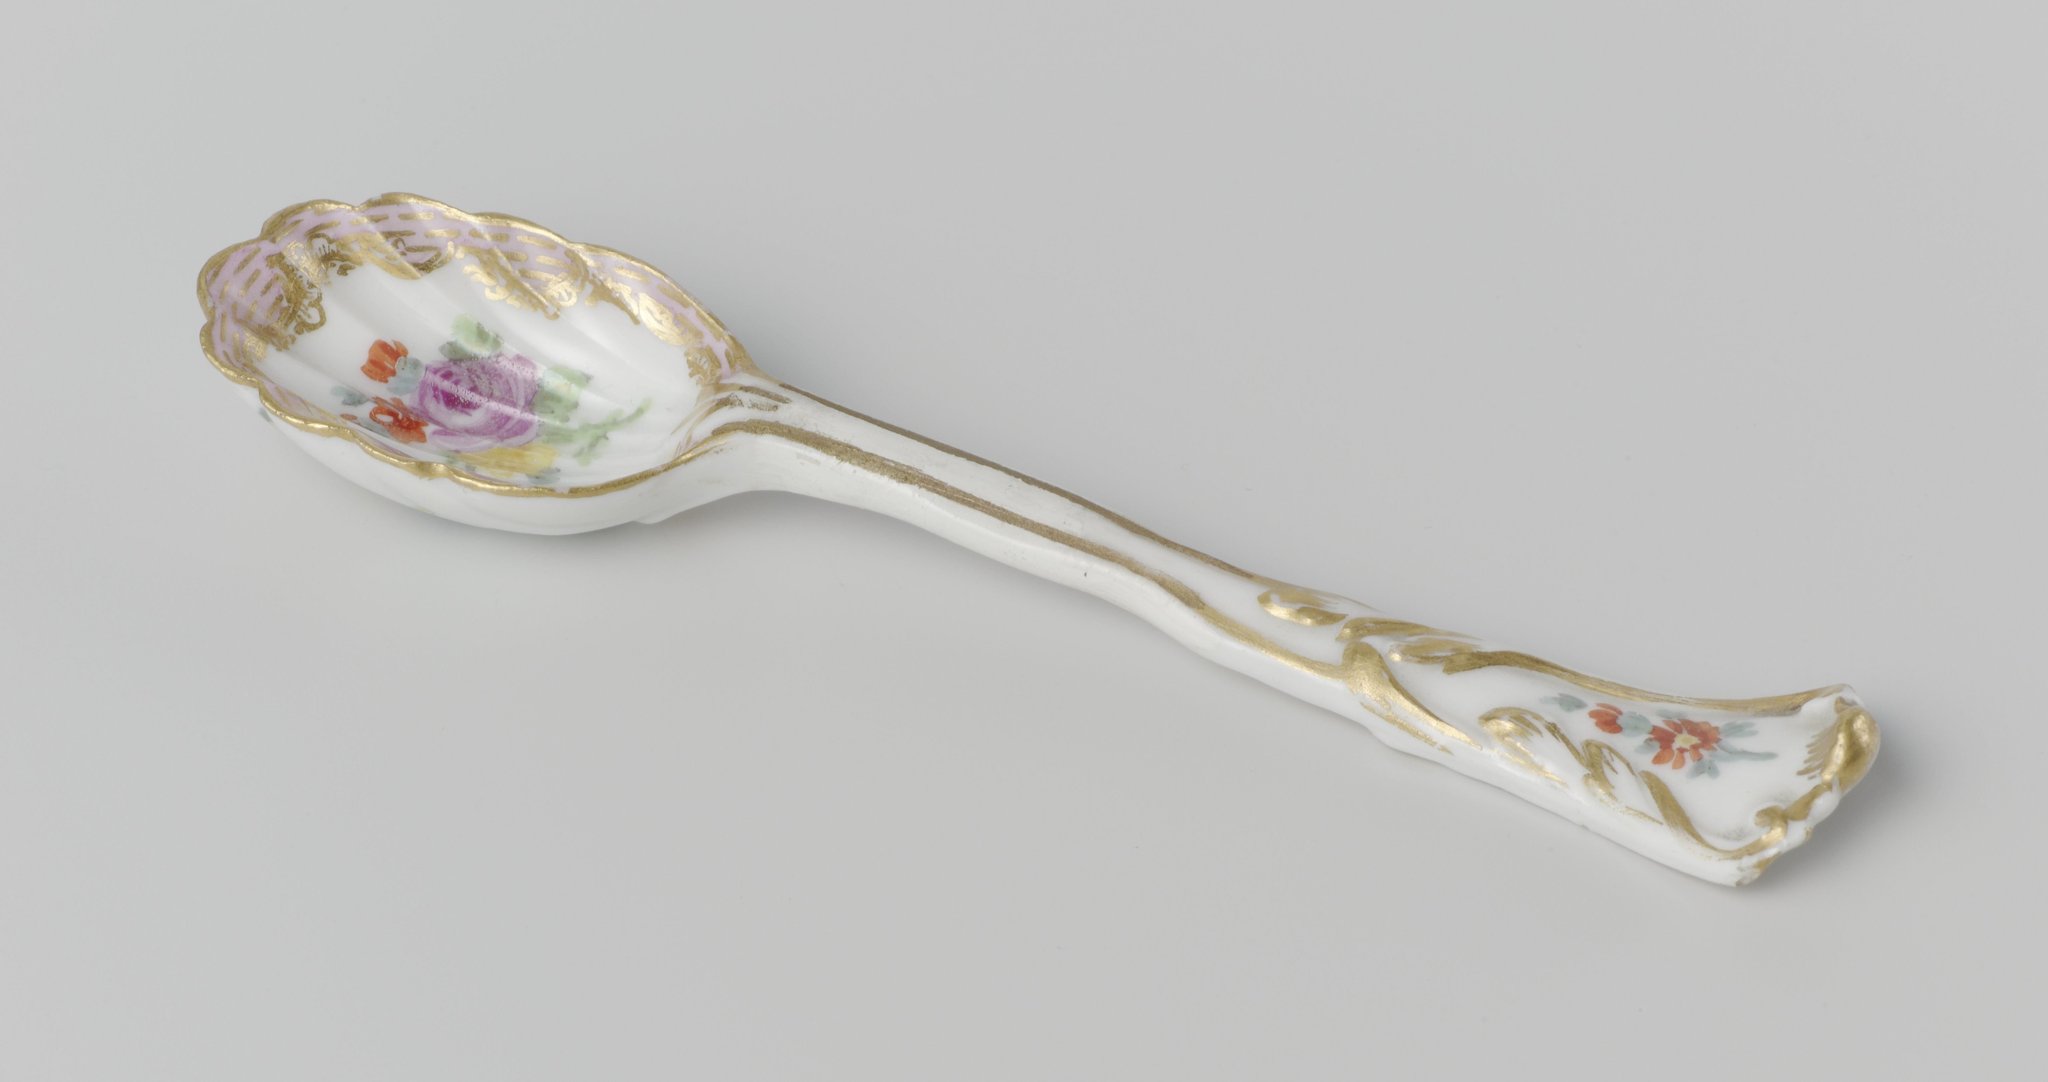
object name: eating drinking utensil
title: Lepel, veelkleurig beschilderd met bloemboeketten.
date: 1800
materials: porcelain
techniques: painted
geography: meissen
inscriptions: factory mark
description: Lepel van beschilderd porselein. De lepel is beschilderd met bloemboeketten en langs de rand een brede strook met strepen in goud op een rose fond, steeds afgezet met een rocaille-ornament in goud. De lepel is gemerkt.